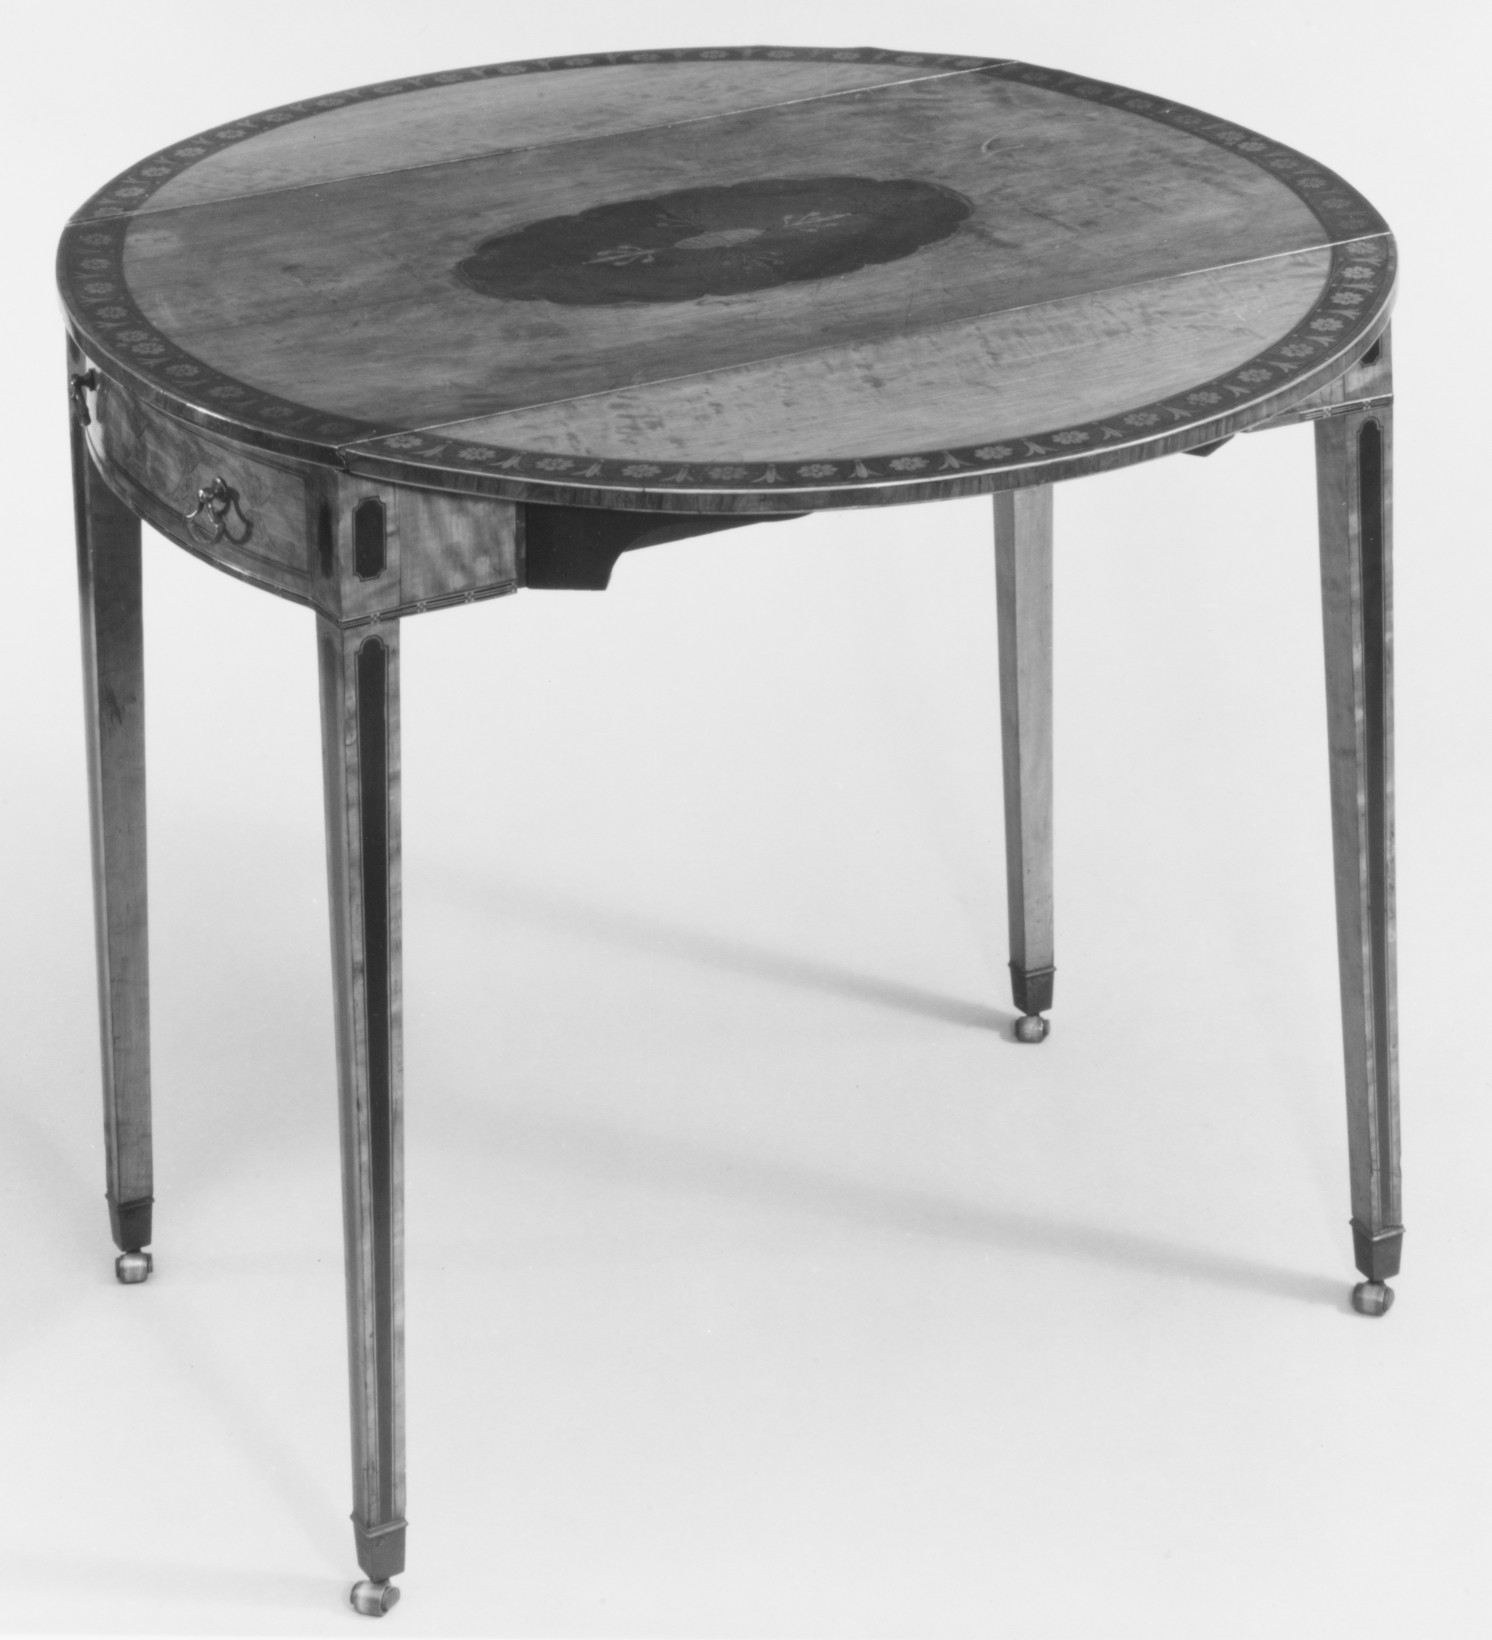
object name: drop leaf table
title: Drop-leaf table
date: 1800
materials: wood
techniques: inlay